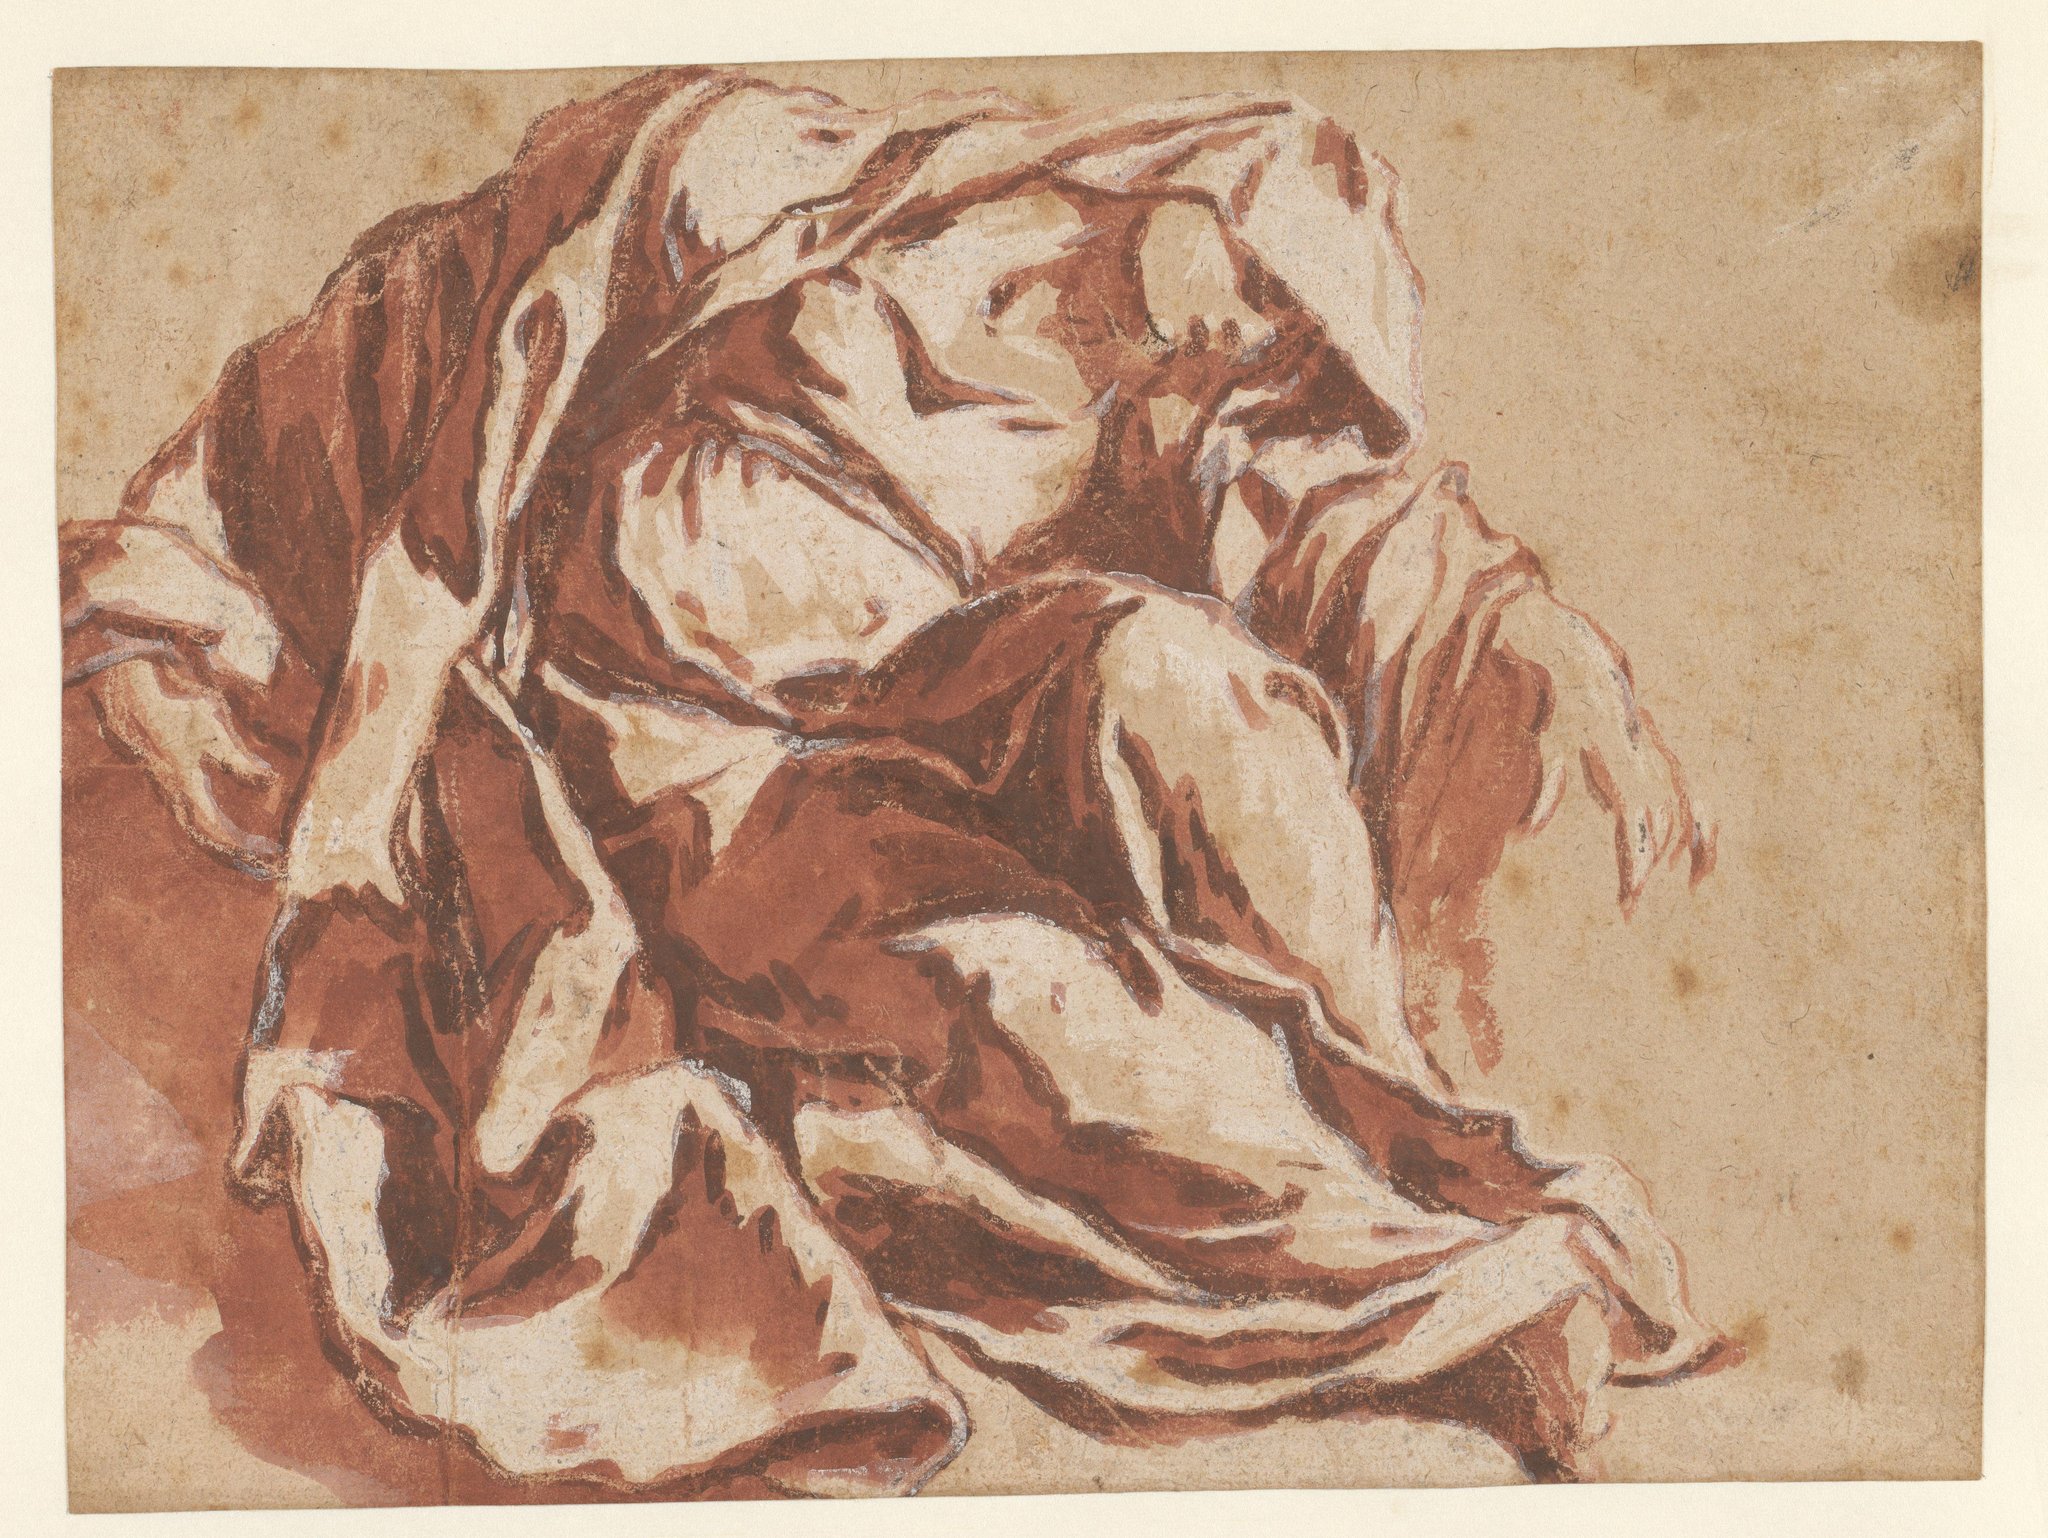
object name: drawing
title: Maria bezwijmende aan de voet van het kruis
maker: gregorio de ferrari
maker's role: draughtsman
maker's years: 1644-1726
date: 1657-1687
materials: paint, paper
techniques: brush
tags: drapery, draped garment, 'gewandgebung', mary and john close together; sometimes mary swooning ~ crucified christ, bystanders at the foot of the cross, among whom mary, mary magdalene and john the evangelist; mary may be shown swooning